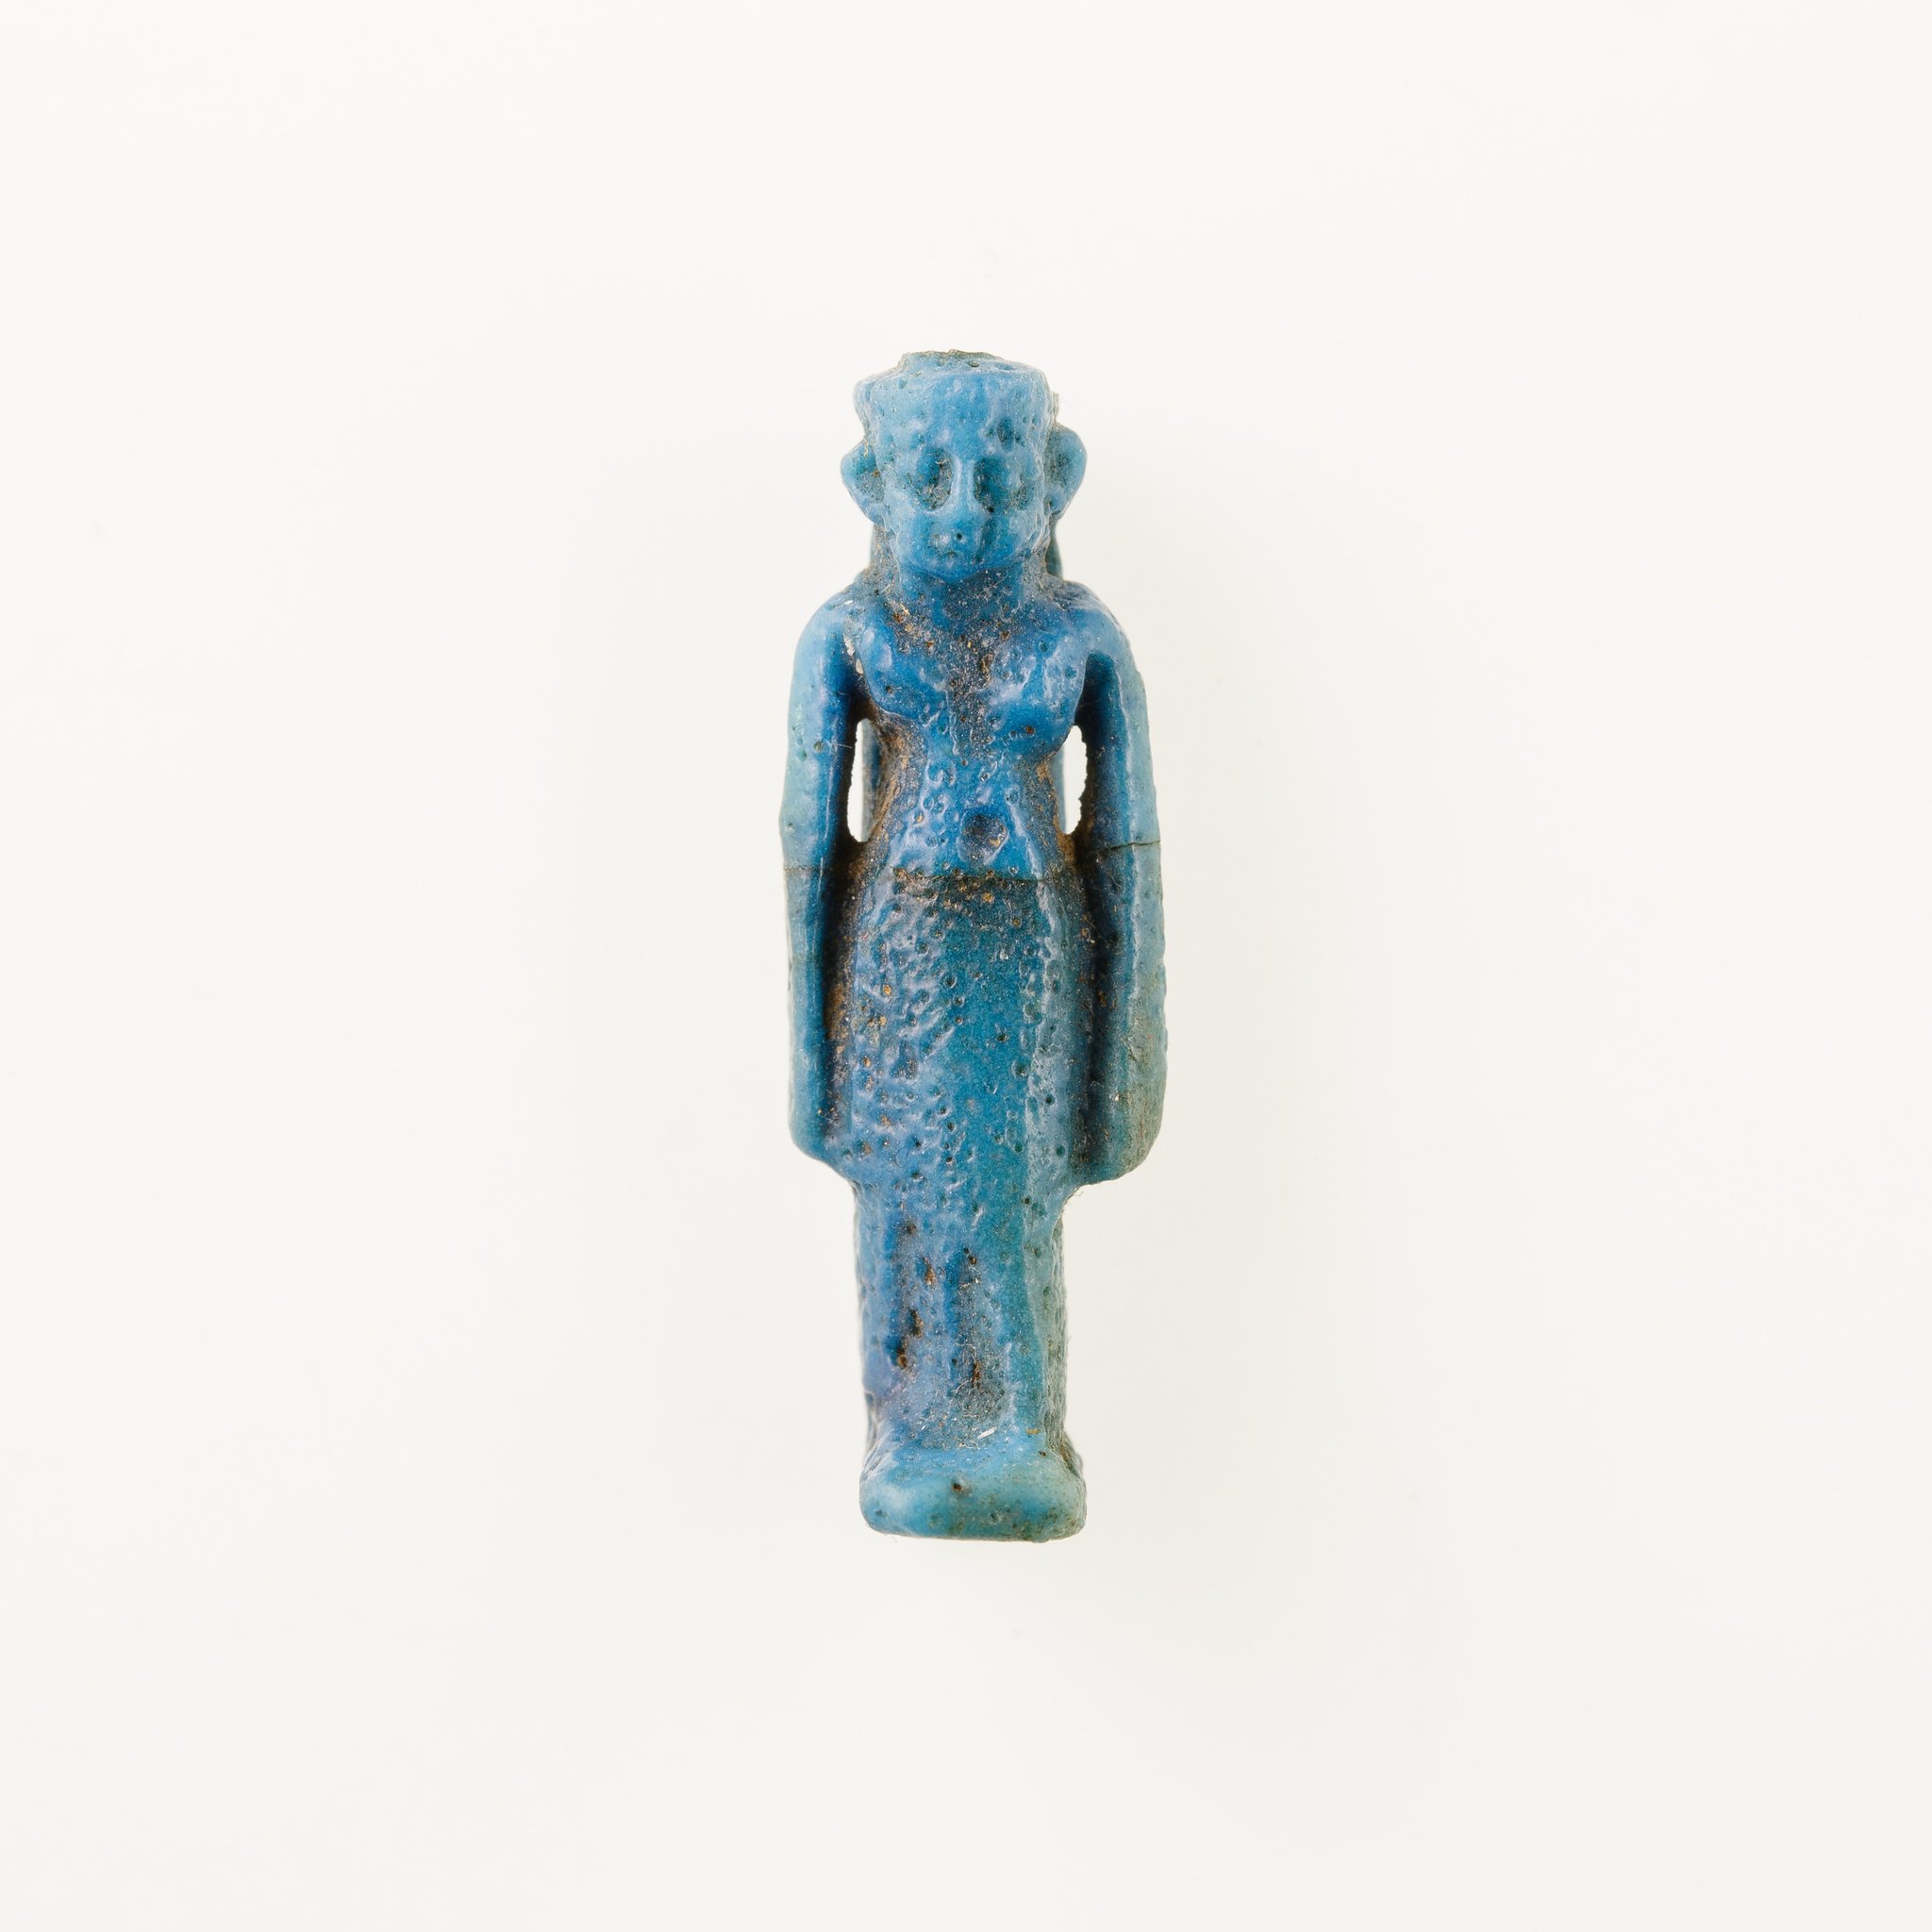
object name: amulet, figure, deity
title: Goddess amulet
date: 1070-343 BCE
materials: faience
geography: egypt